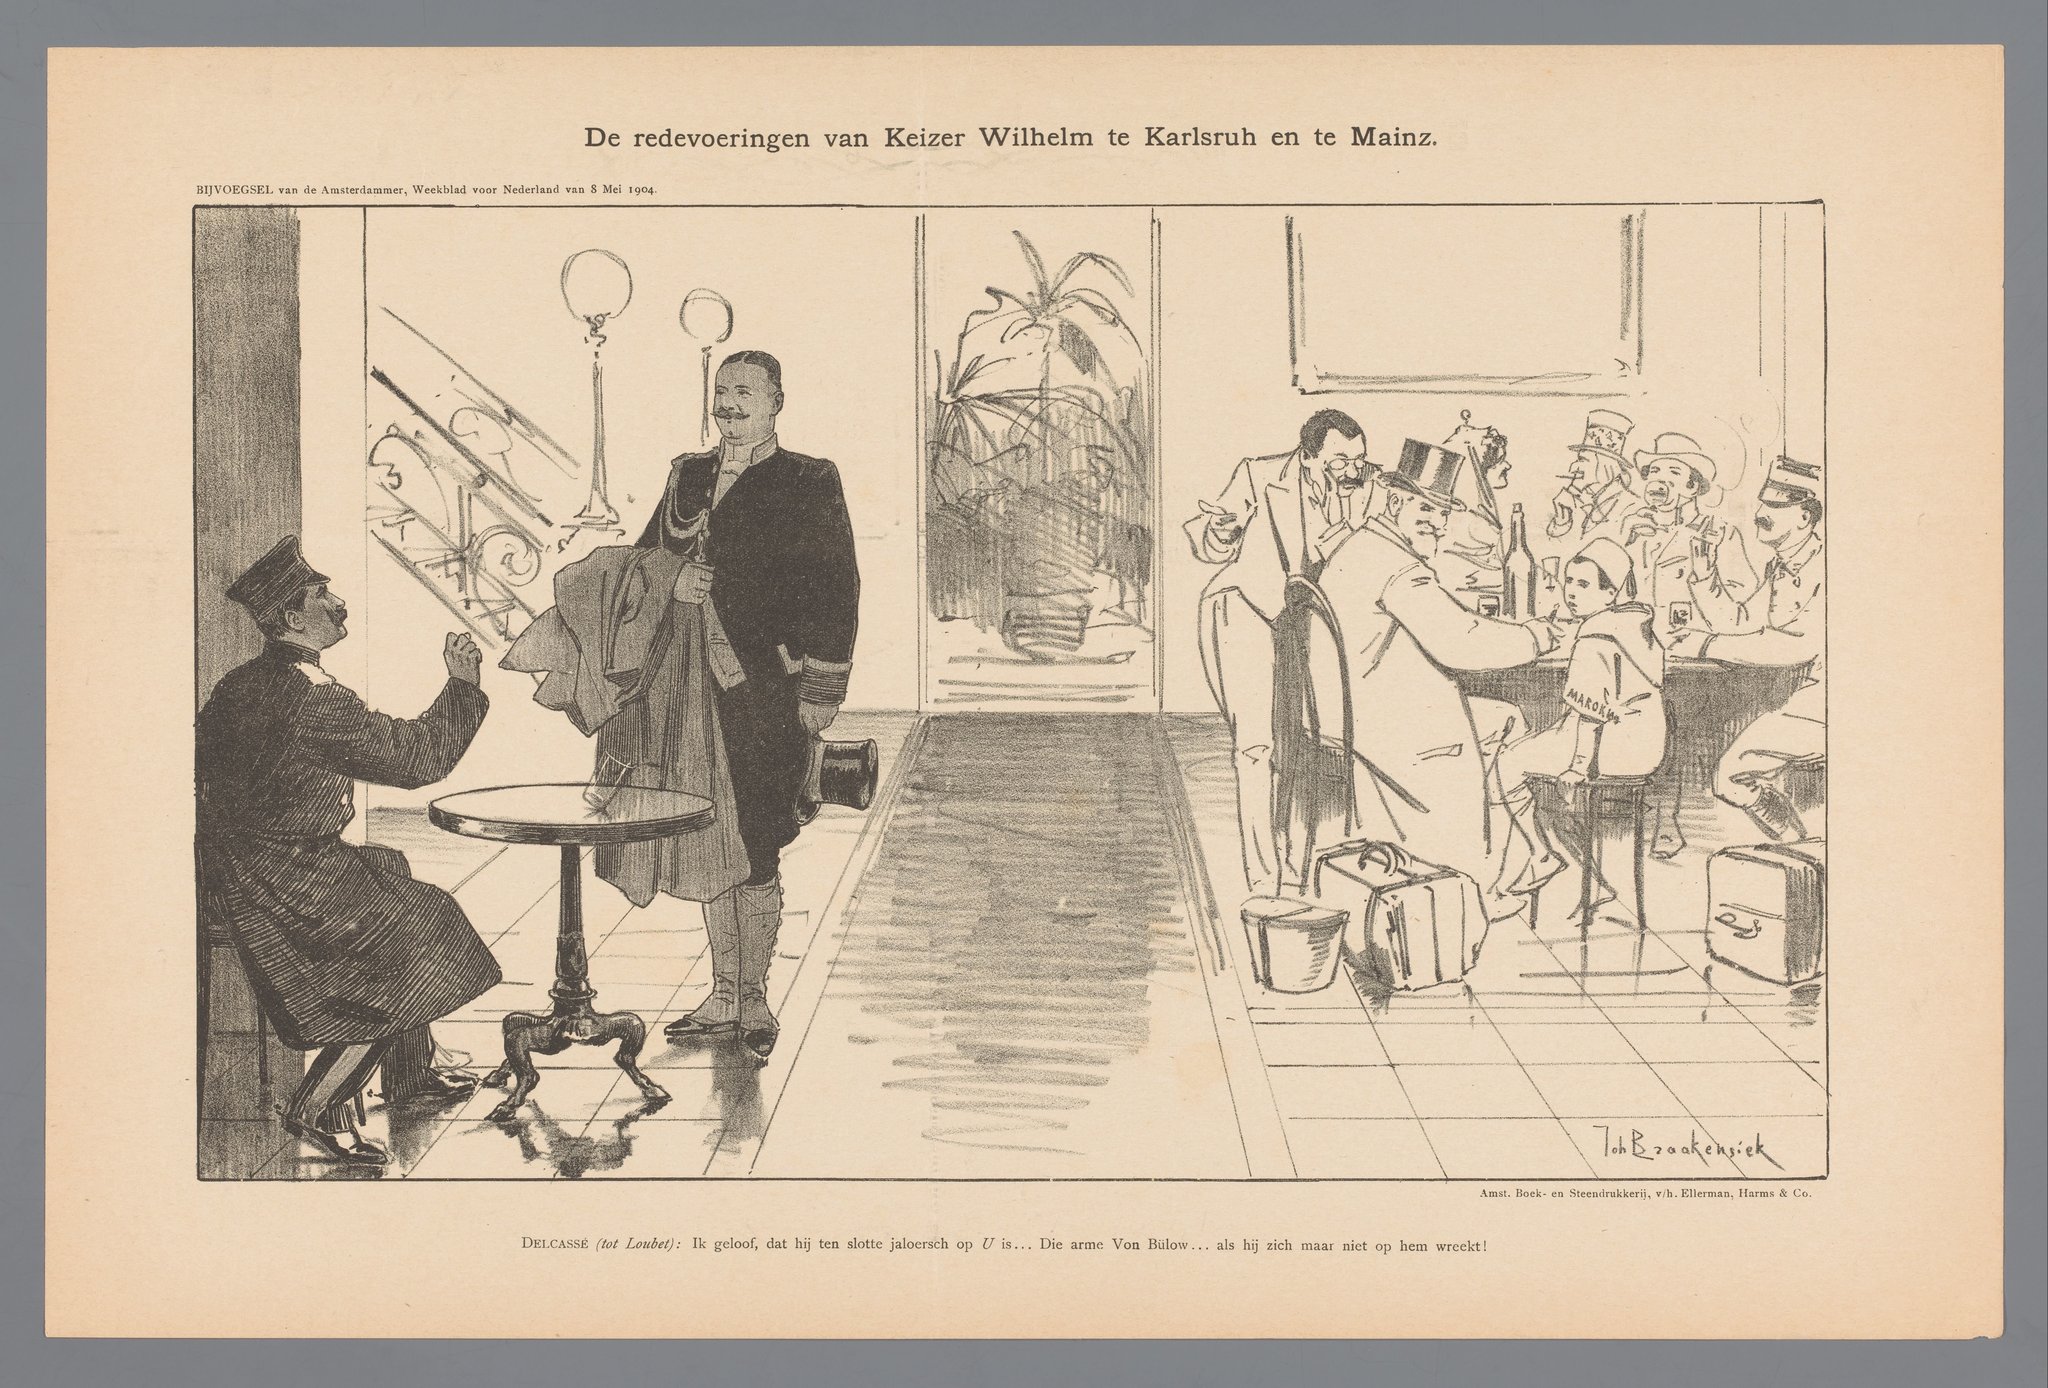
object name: cartoon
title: De redevoeringen van Keizier Wilhelm te Karlsruh en te Mainz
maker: johan braakensiek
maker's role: draughtsman, print maker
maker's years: 1858-1940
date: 1904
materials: paper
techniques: lithograph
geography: amsterdam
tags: wilhelm ii (keizer van duitsland), historical persons, emperor, political caricatures and satires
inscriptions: date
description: Prent uit het bijvoegsel van: De Amsterdammer. Weekblad voor Nederland, 8 mei 1904.